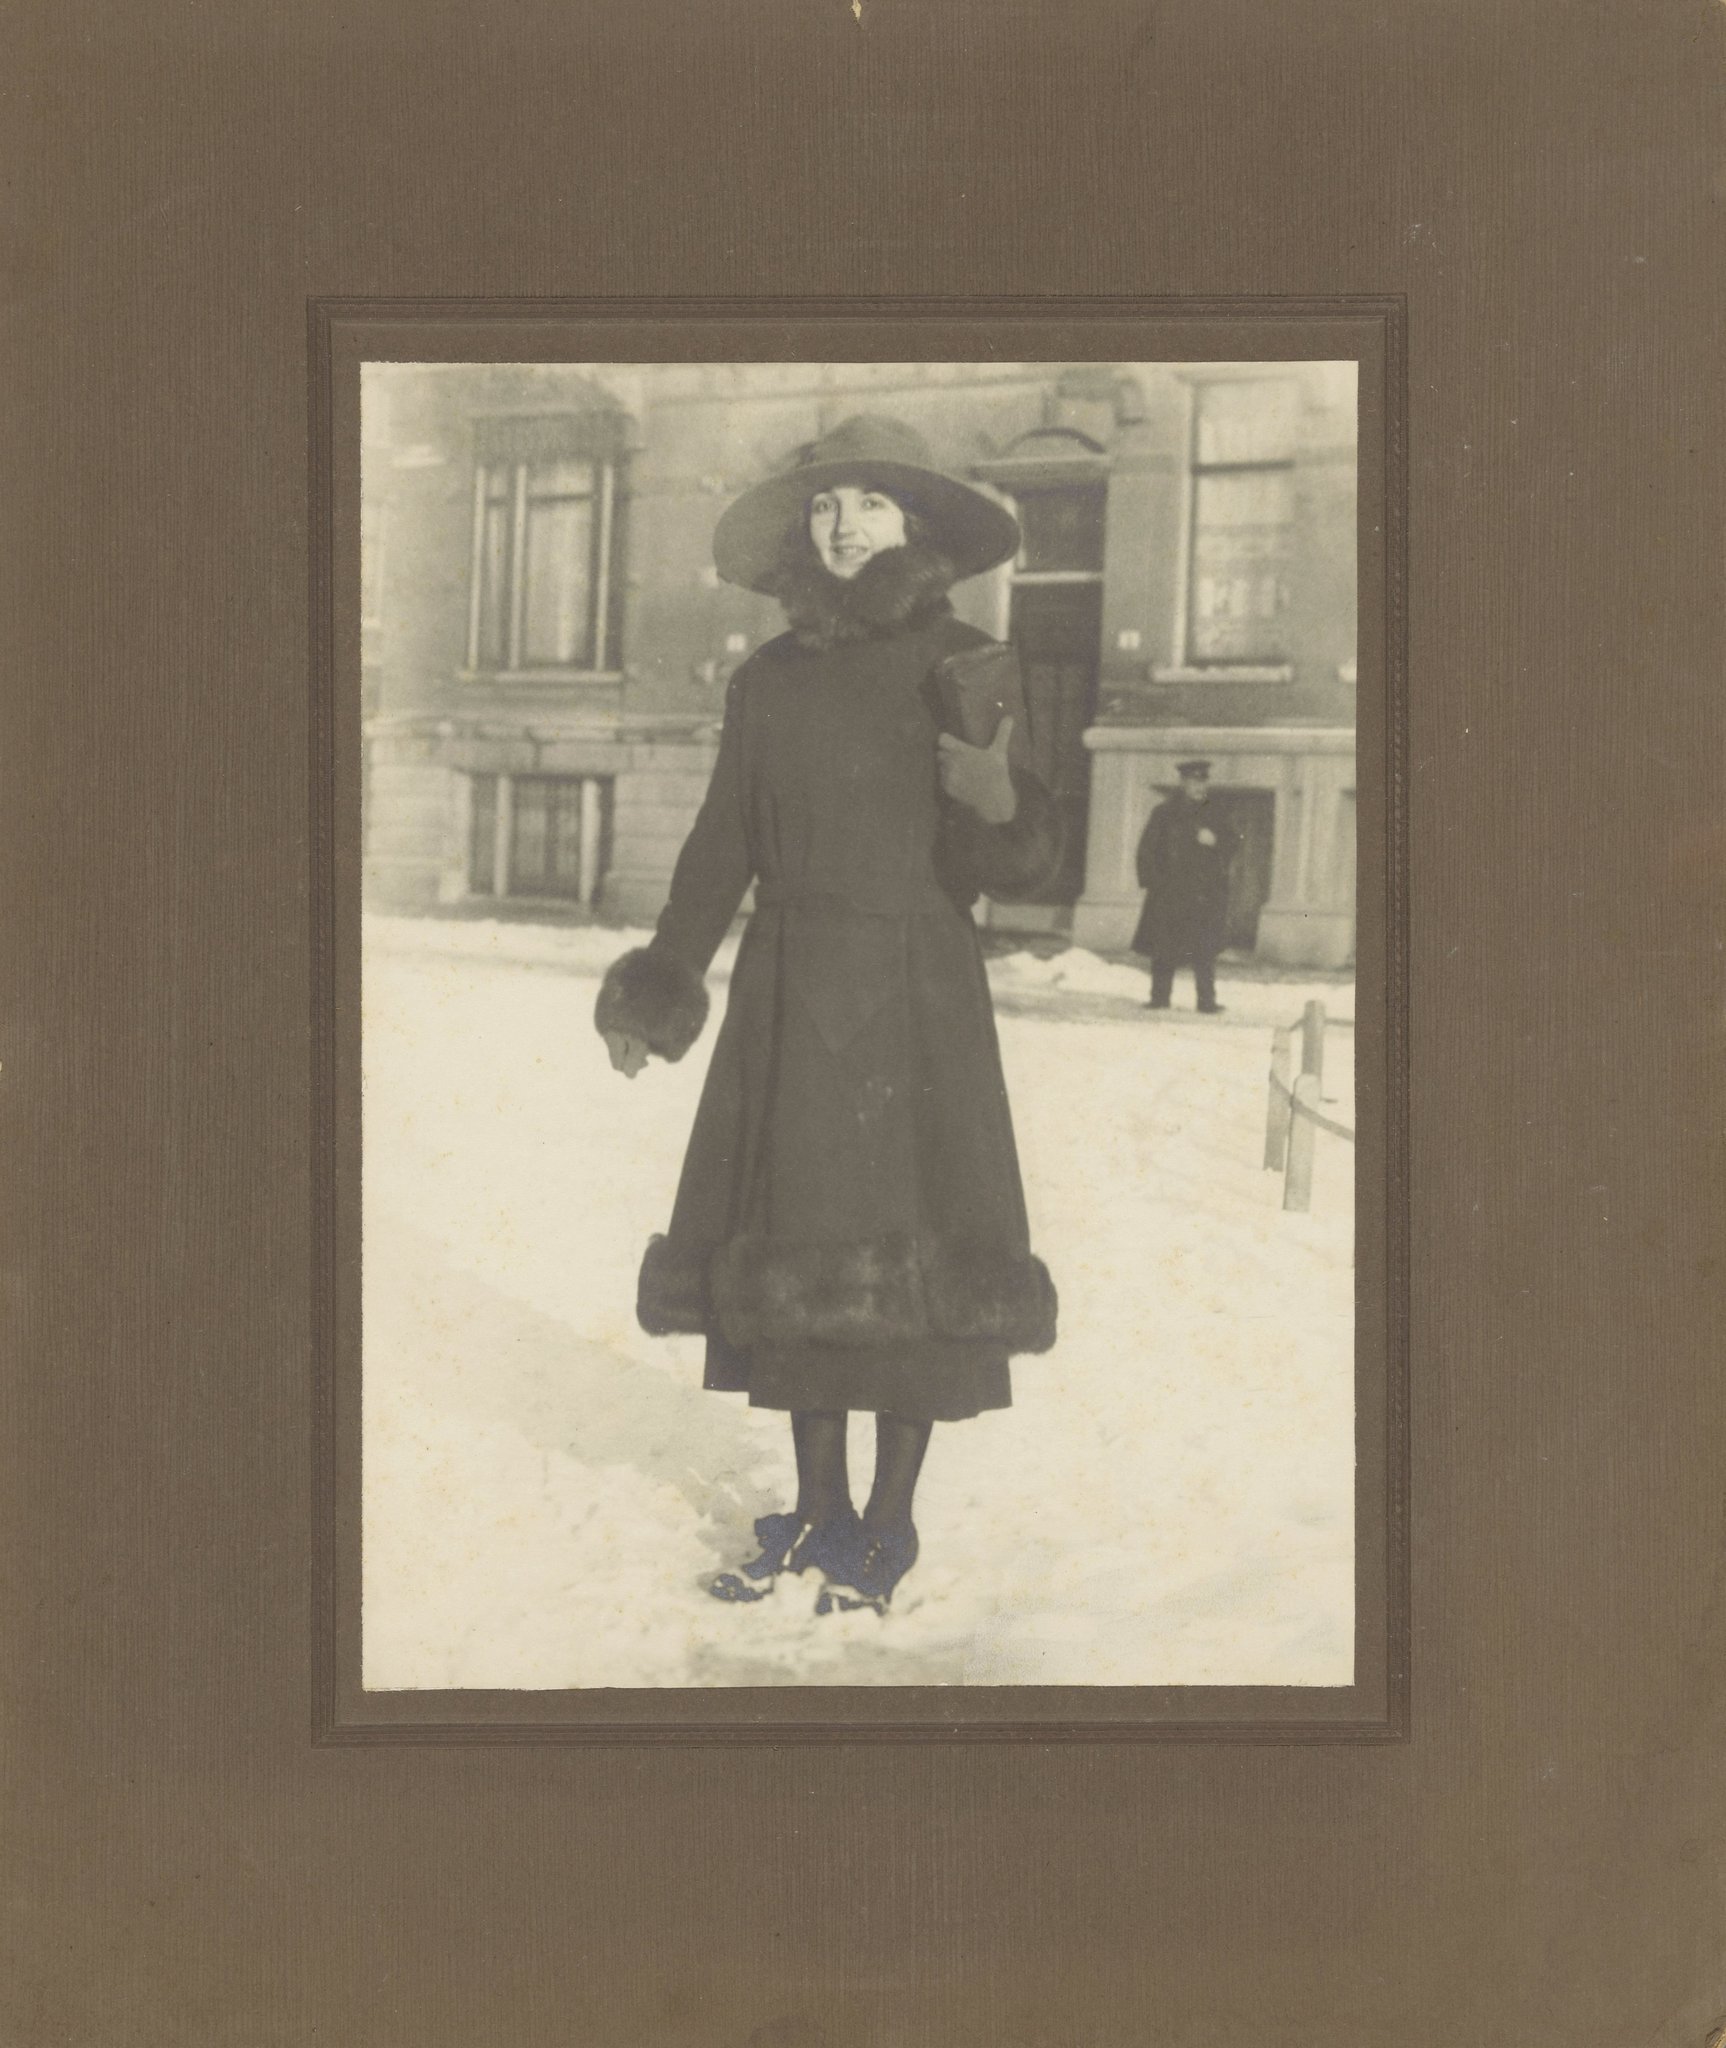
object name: photograph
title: Portret van een onbekende vrouw met bontjas op straat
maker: Anonymous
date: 1910-1930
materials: cardboard, paper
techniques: carbon print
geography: netherlands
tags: historical persons - bb - woman, snow